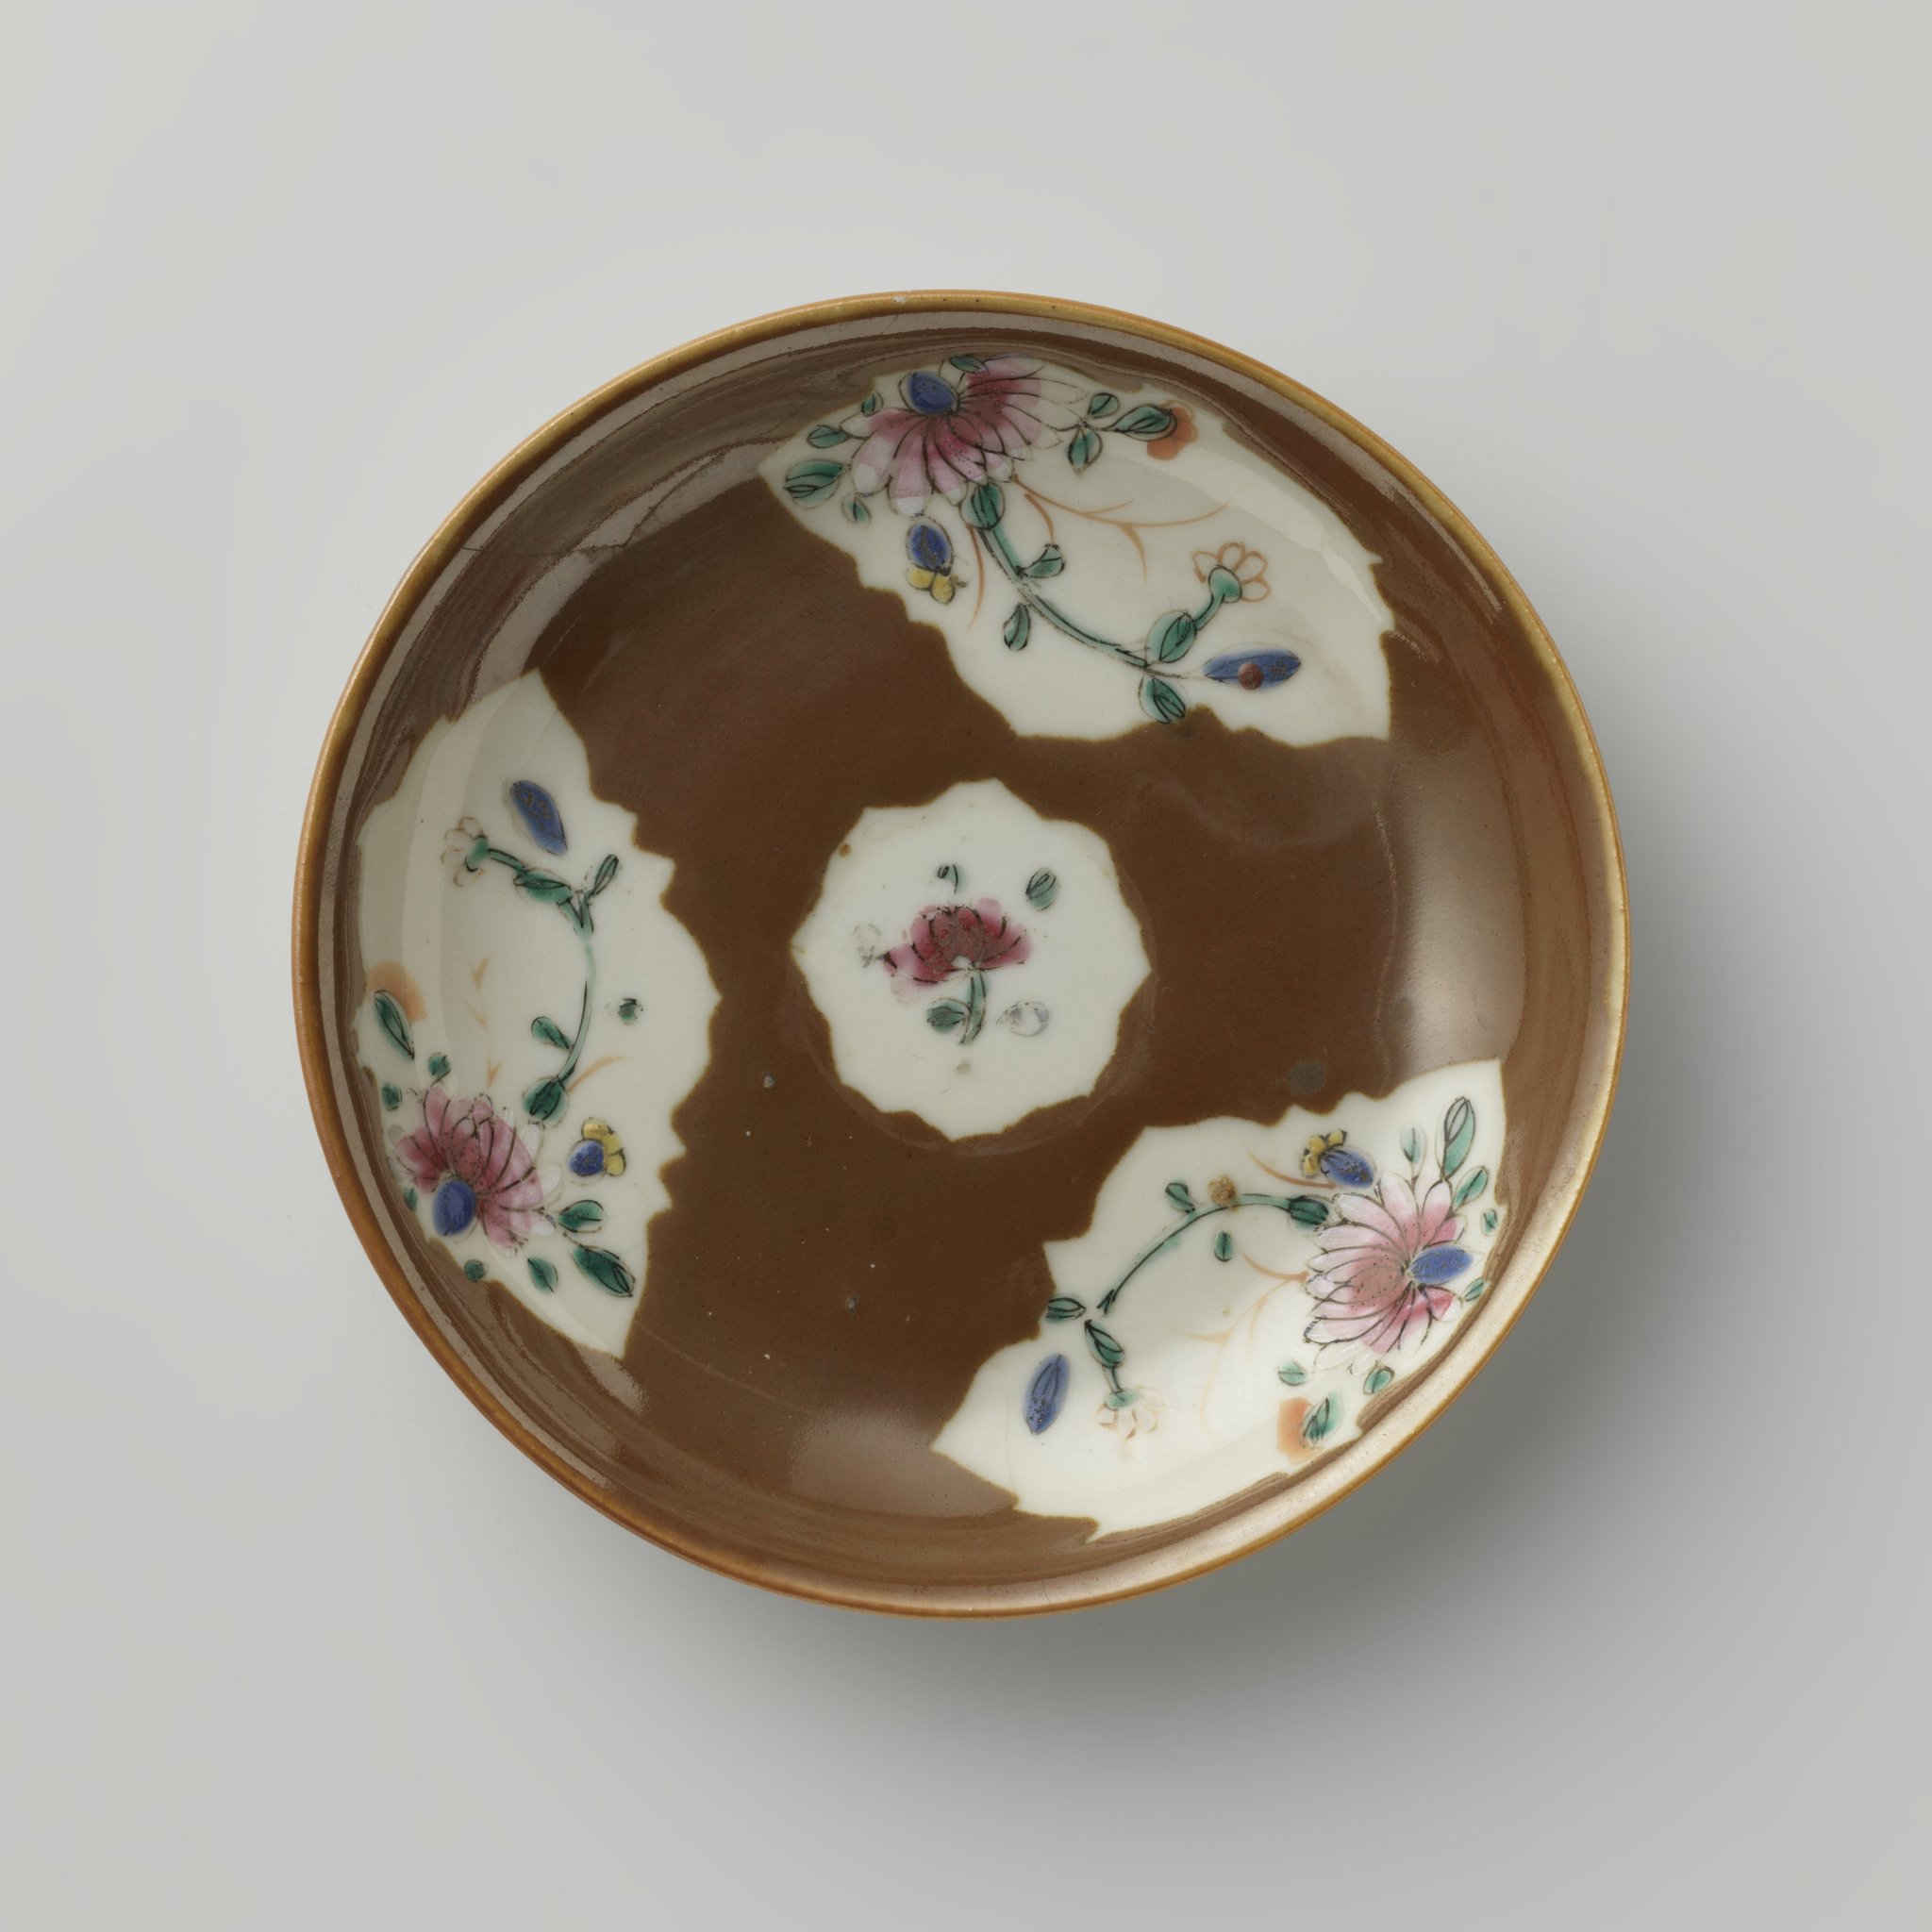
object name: kop en schotel, kop en schotel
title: Saucer with flower sprays in panels on a brown glaze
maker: Anonymous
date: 1730-1760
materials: glaze, paint, porcelain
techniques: firing, turning, vitrification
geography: china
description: Schotel van porselein, bedekt met een bruin glazuur en beschilderd in blauw, rood, roze, groen, geel en zwart. De schotel is aan de voorzijde bedekt met een bruin glazuur met hierin uitgespaard vier bladvormige cartouches met bloemtakken. Schotel is gebroken geweest. Famille rose met monochroom bruin.